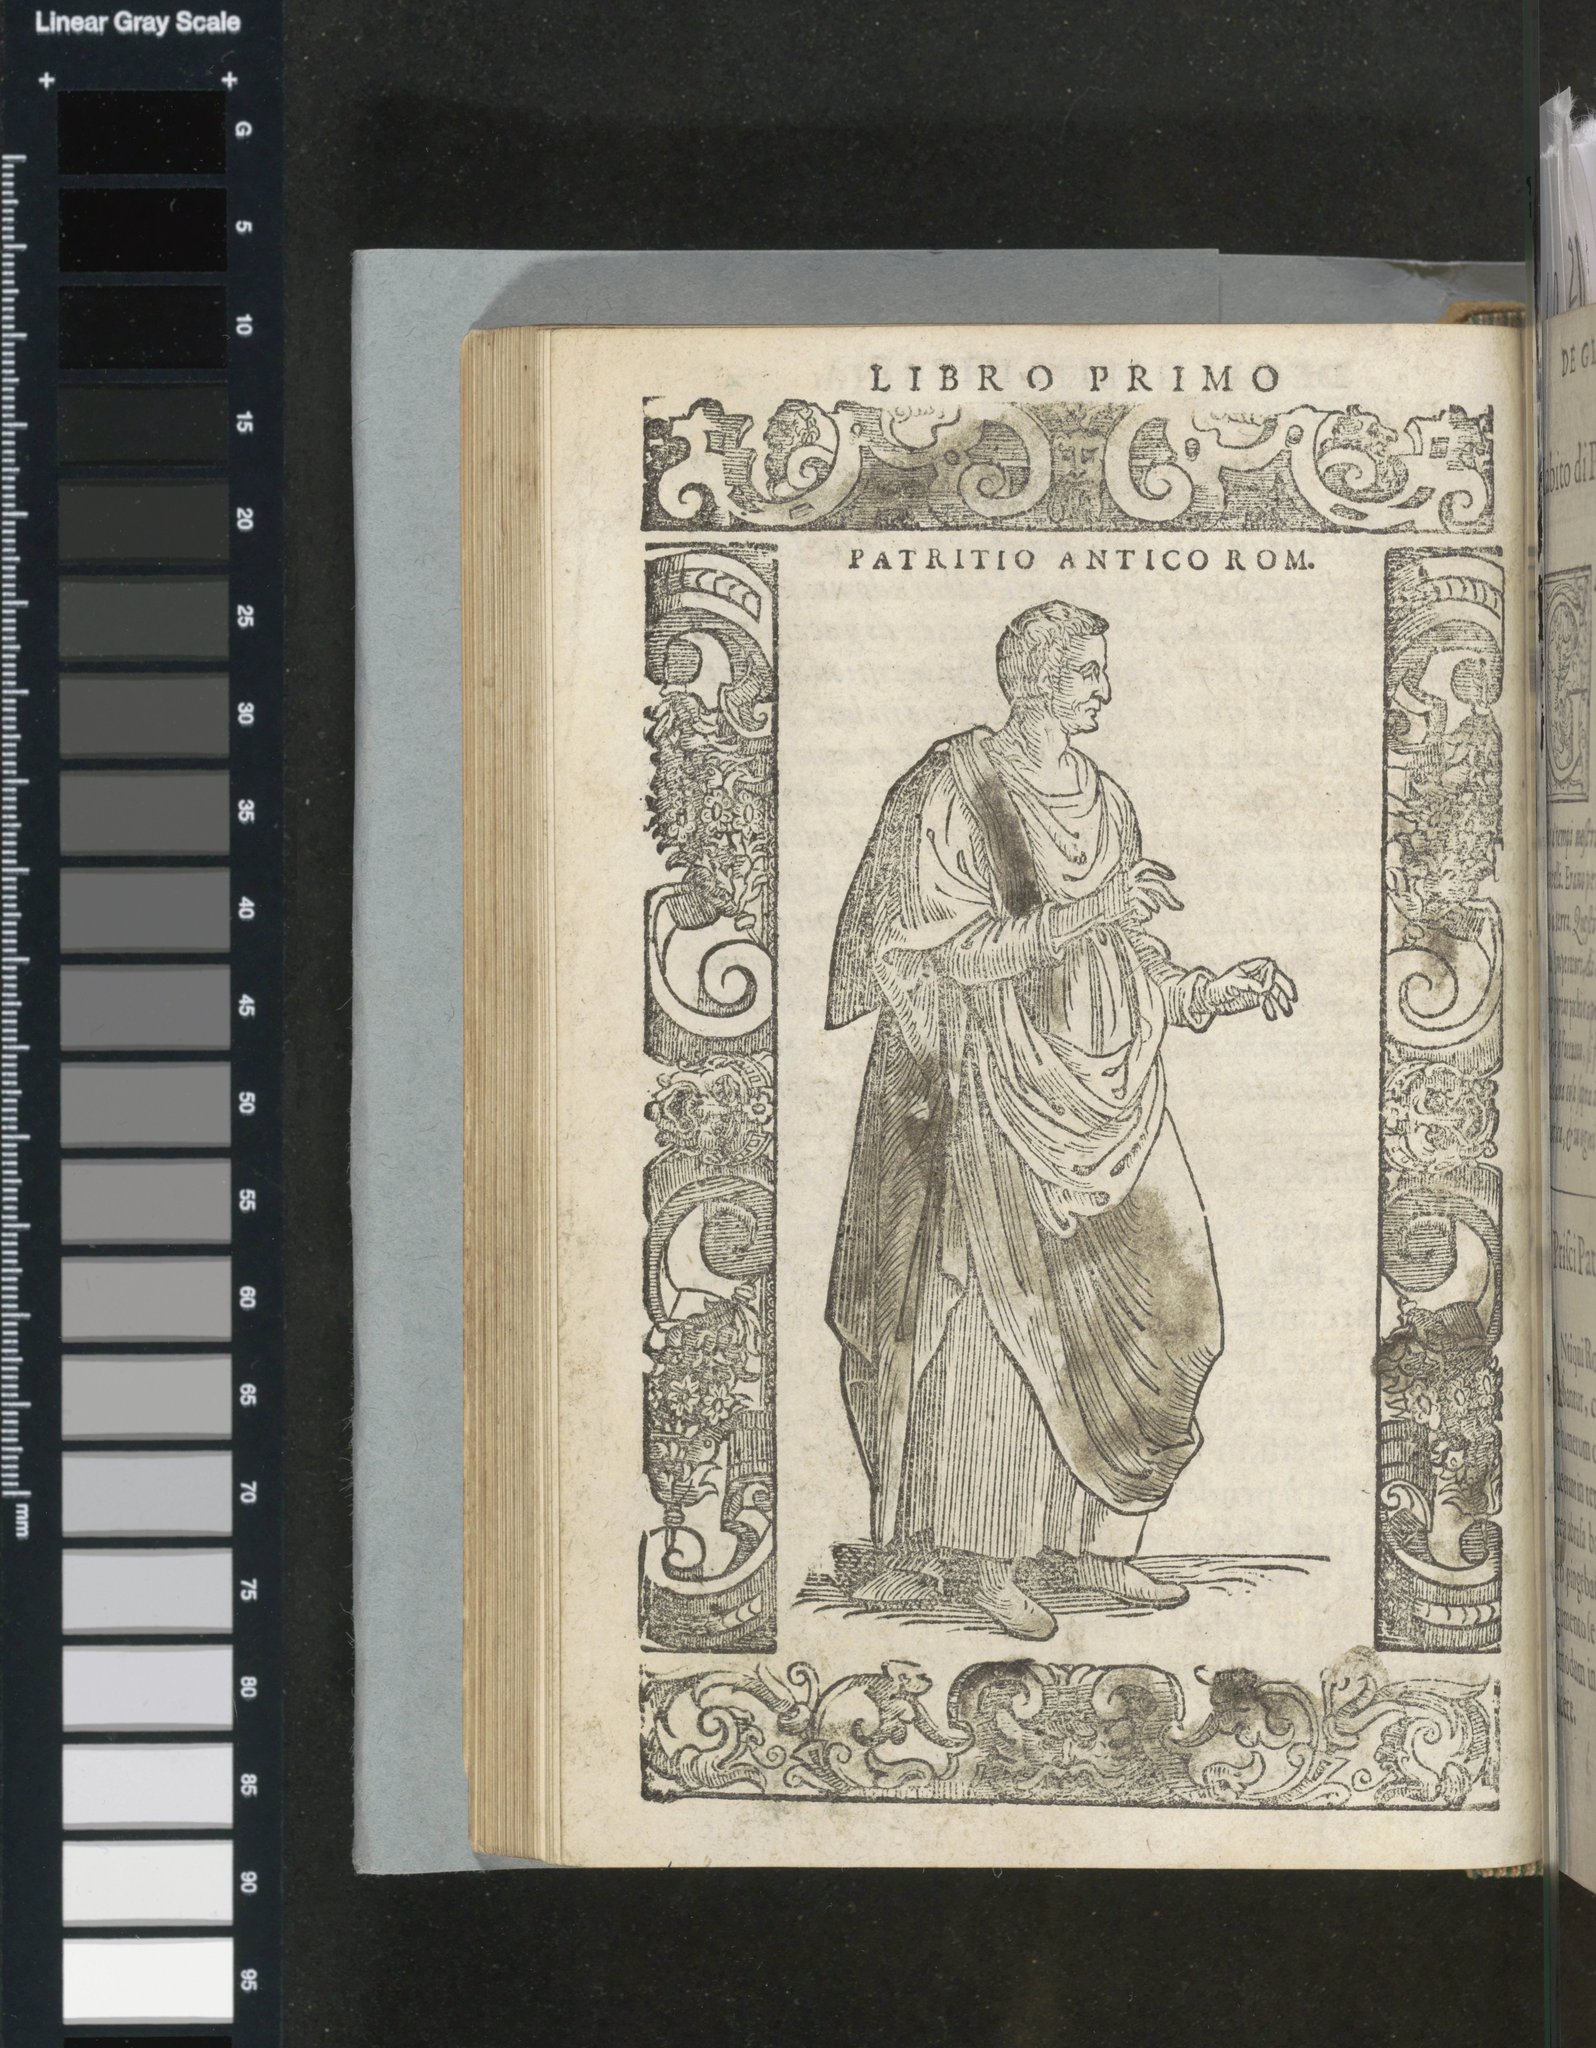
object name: costume print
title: Romeins patricier in toga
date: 1598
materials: paper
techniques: woodcut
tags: other sovereign, mantle, gown, dress (symbol of sovereignty)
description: Romeins patricier in toga, naar rechts, in ornamentrand